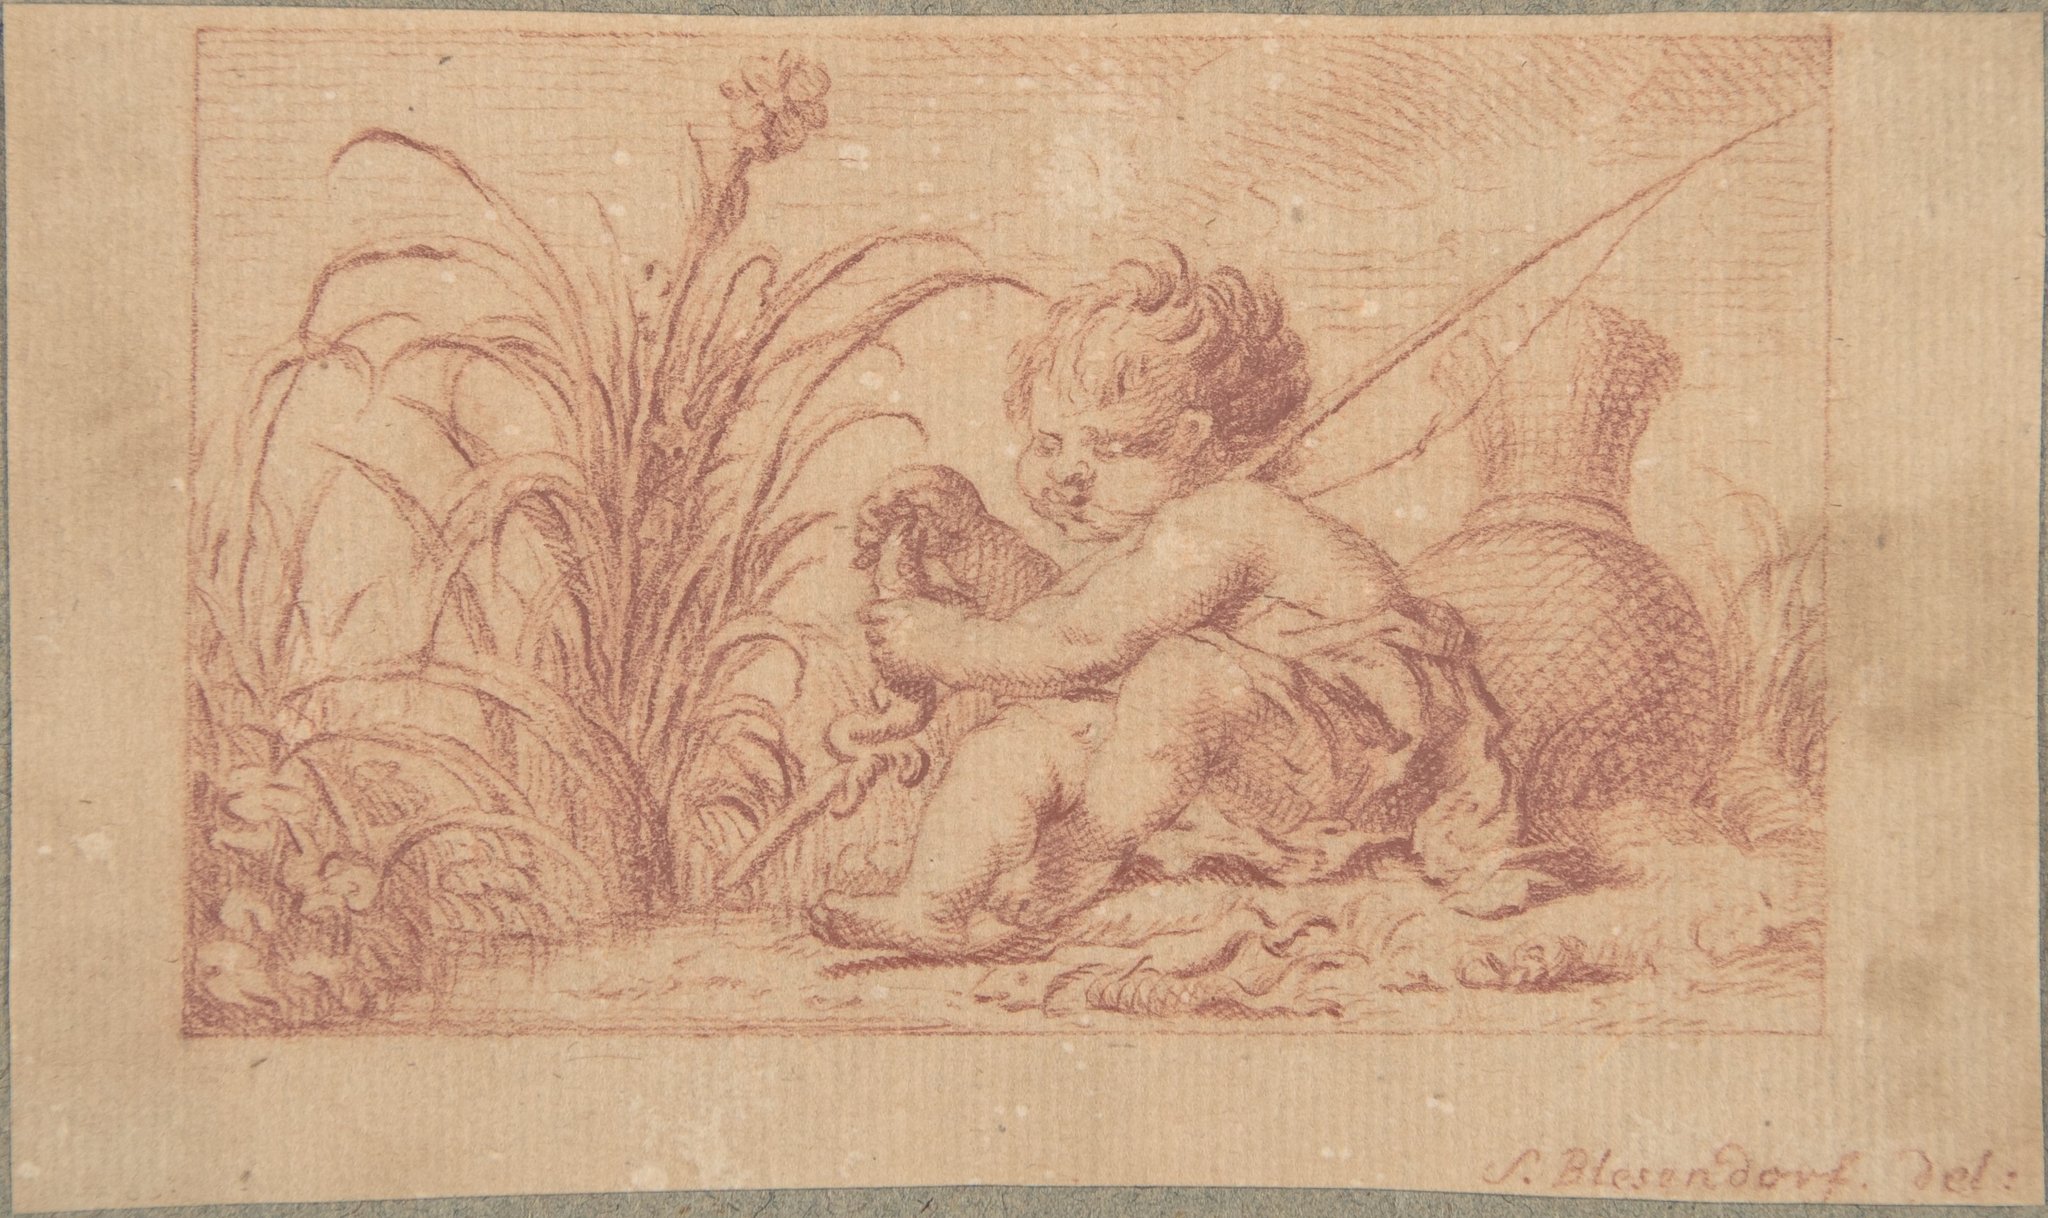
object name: drawing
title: A Fishing Putto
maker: sophia blesendorf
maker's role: artist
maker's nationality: german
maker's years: 17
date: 1667-1700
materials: chalk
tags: fishing,putti